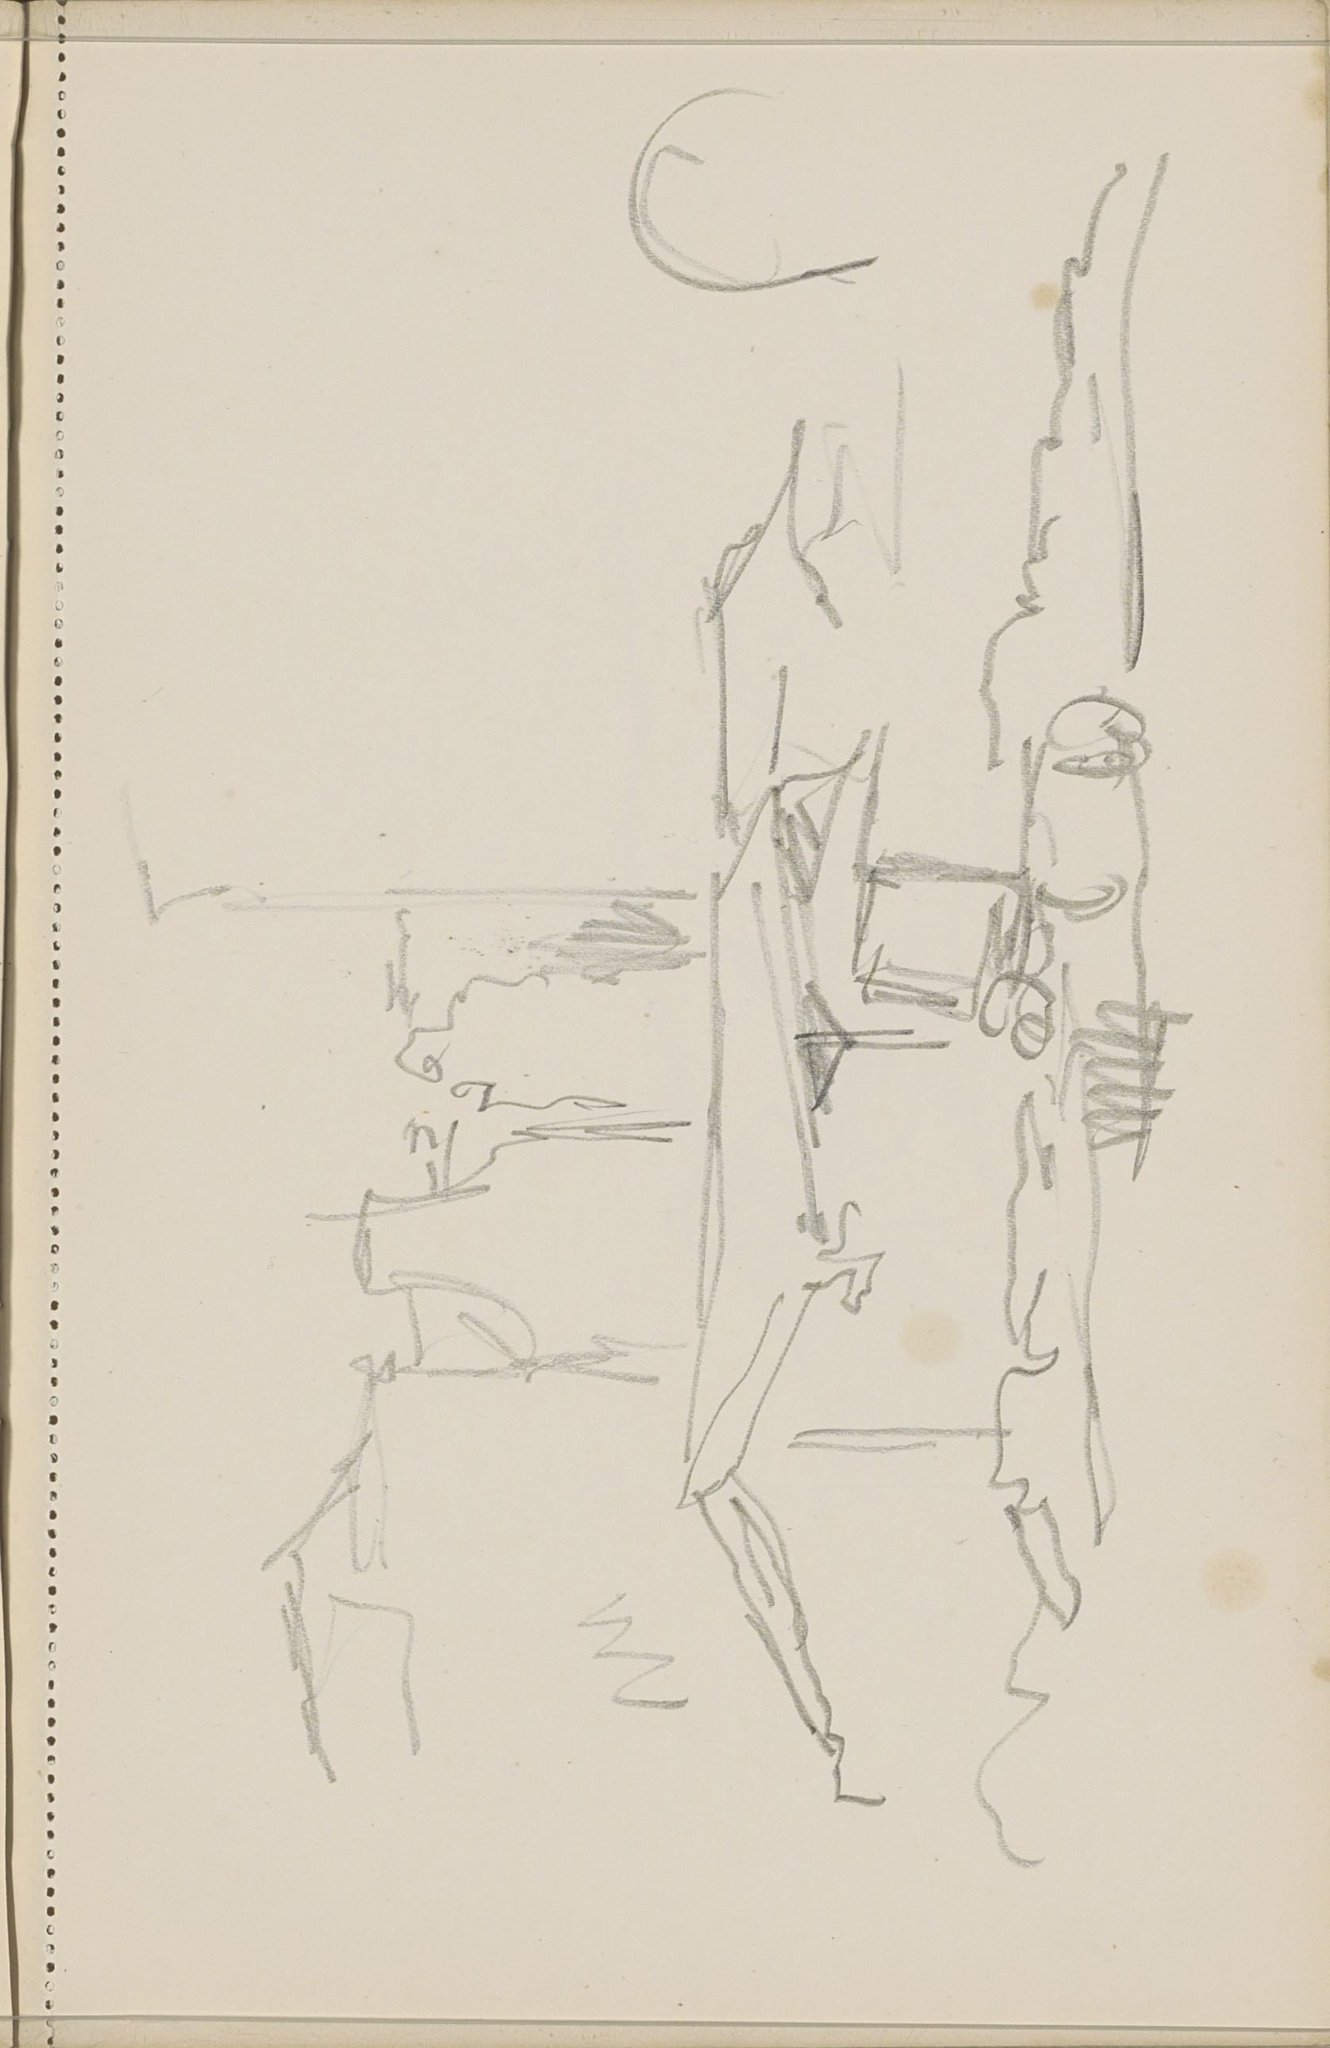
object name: sketchbook leaf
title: Overdekte kramen op een straat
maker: cornelis vreedenburgh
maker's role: draughtsman, print maker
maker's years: 1880-1946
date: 1890-1946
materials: paper, pencil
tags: stall, booth (~ market), street (+ city(-scape) with figures, staffage)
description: Blad 26 recto uit een schetsboek met 59 bladen.